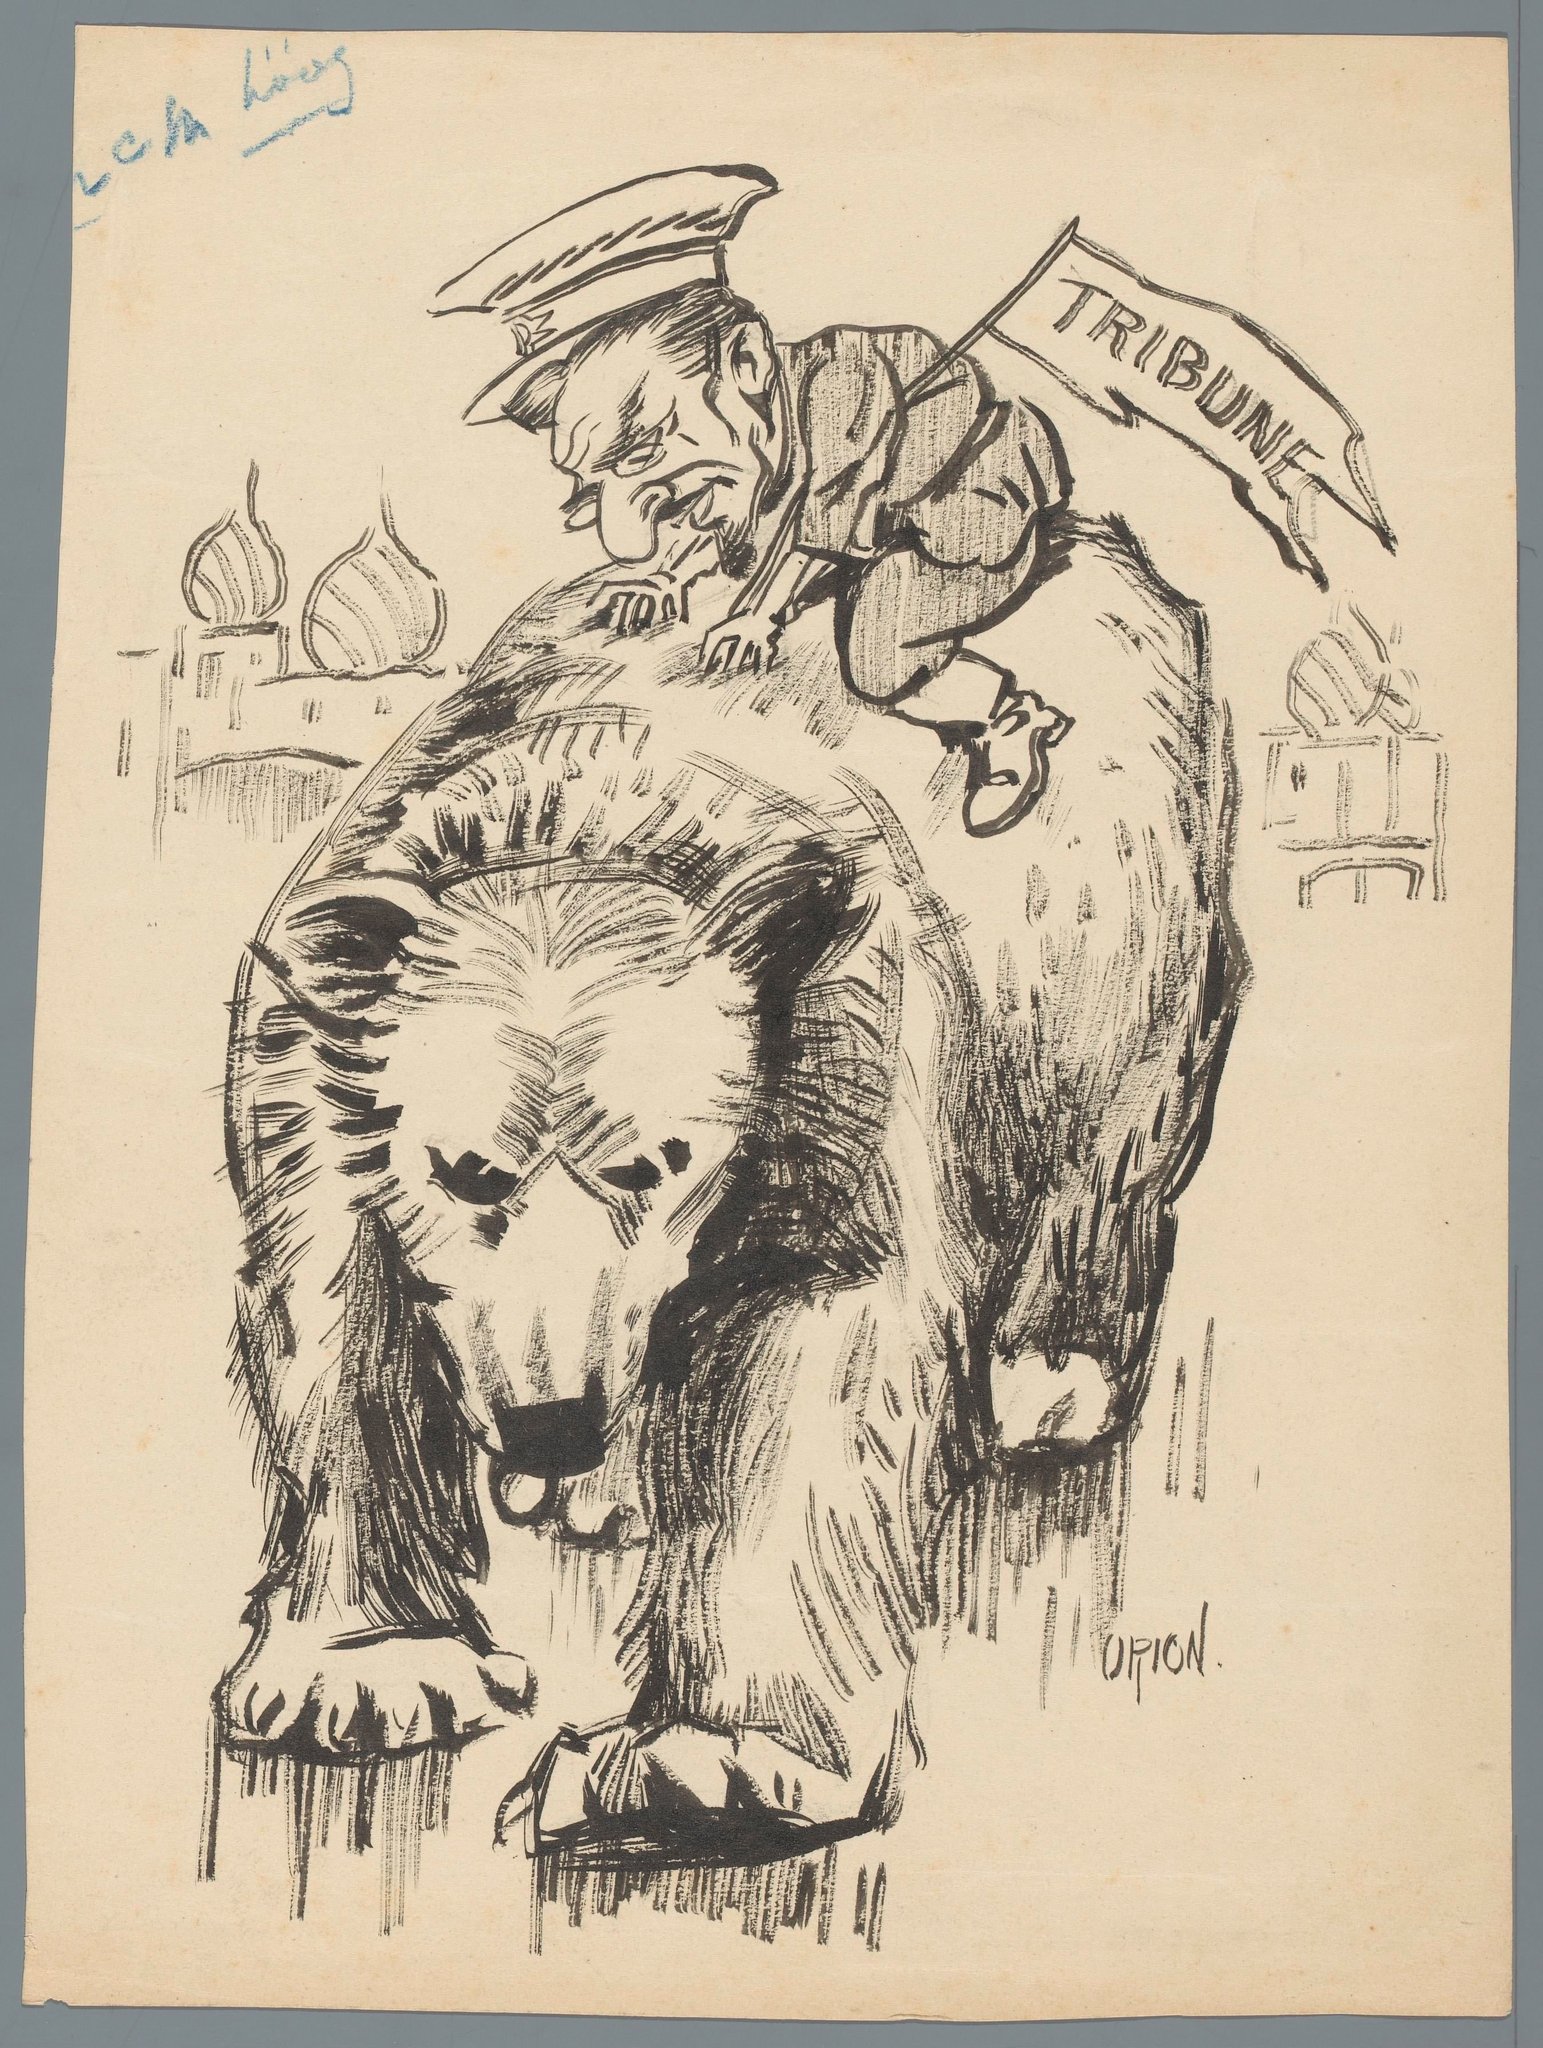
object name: cartoon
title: David Wijnkoop en de Russische beer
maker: patricq kroon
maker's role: draughtsman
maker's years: 1862-1941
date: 1916-1925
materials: ink, paper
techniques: pen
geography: netherlands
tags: personifications of countries, nations, states, districts, etc. (+ nation; national), political caricatures and satires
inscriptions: inscription: ‘David - Sovjetruiter / David: O, zoo! ... maar gevaarlijk als ie begint te bokken.’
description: De Nederlandse communist David Wijnkoop, hoofdredacteur van het dagblad De Tribune, klimt op de Russische beer. Ontwerp voor een politieke spotprent.